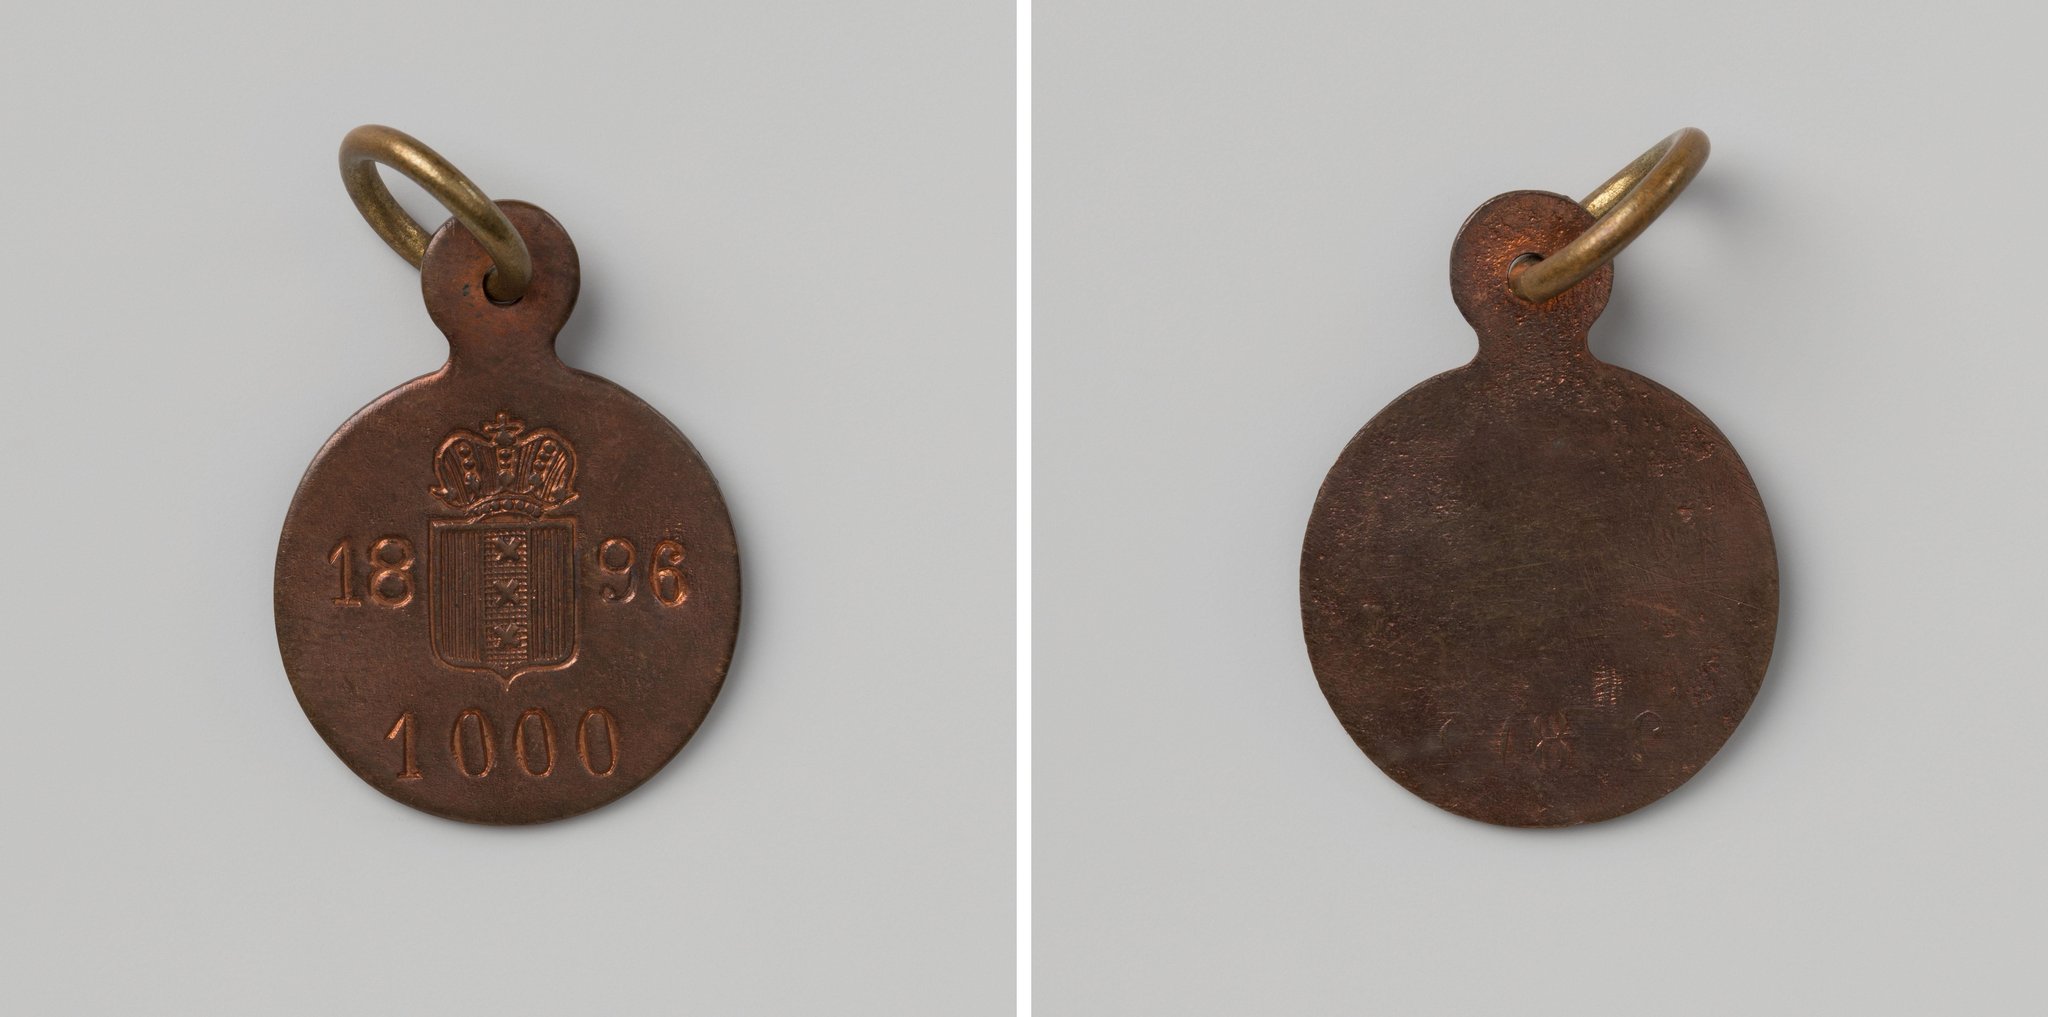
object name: tax token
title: Stad Amsterdam, loodje met no. 1000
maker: Anonymous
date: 1896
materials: brass, copper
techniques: striking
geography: amsterdam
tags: amsterdam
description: eenzijdig loodje aan draagoog en draagring. Voorzijde: gekroond wapenschild tussen jaartal boven cijfer 1000. Keerzijde: blanco